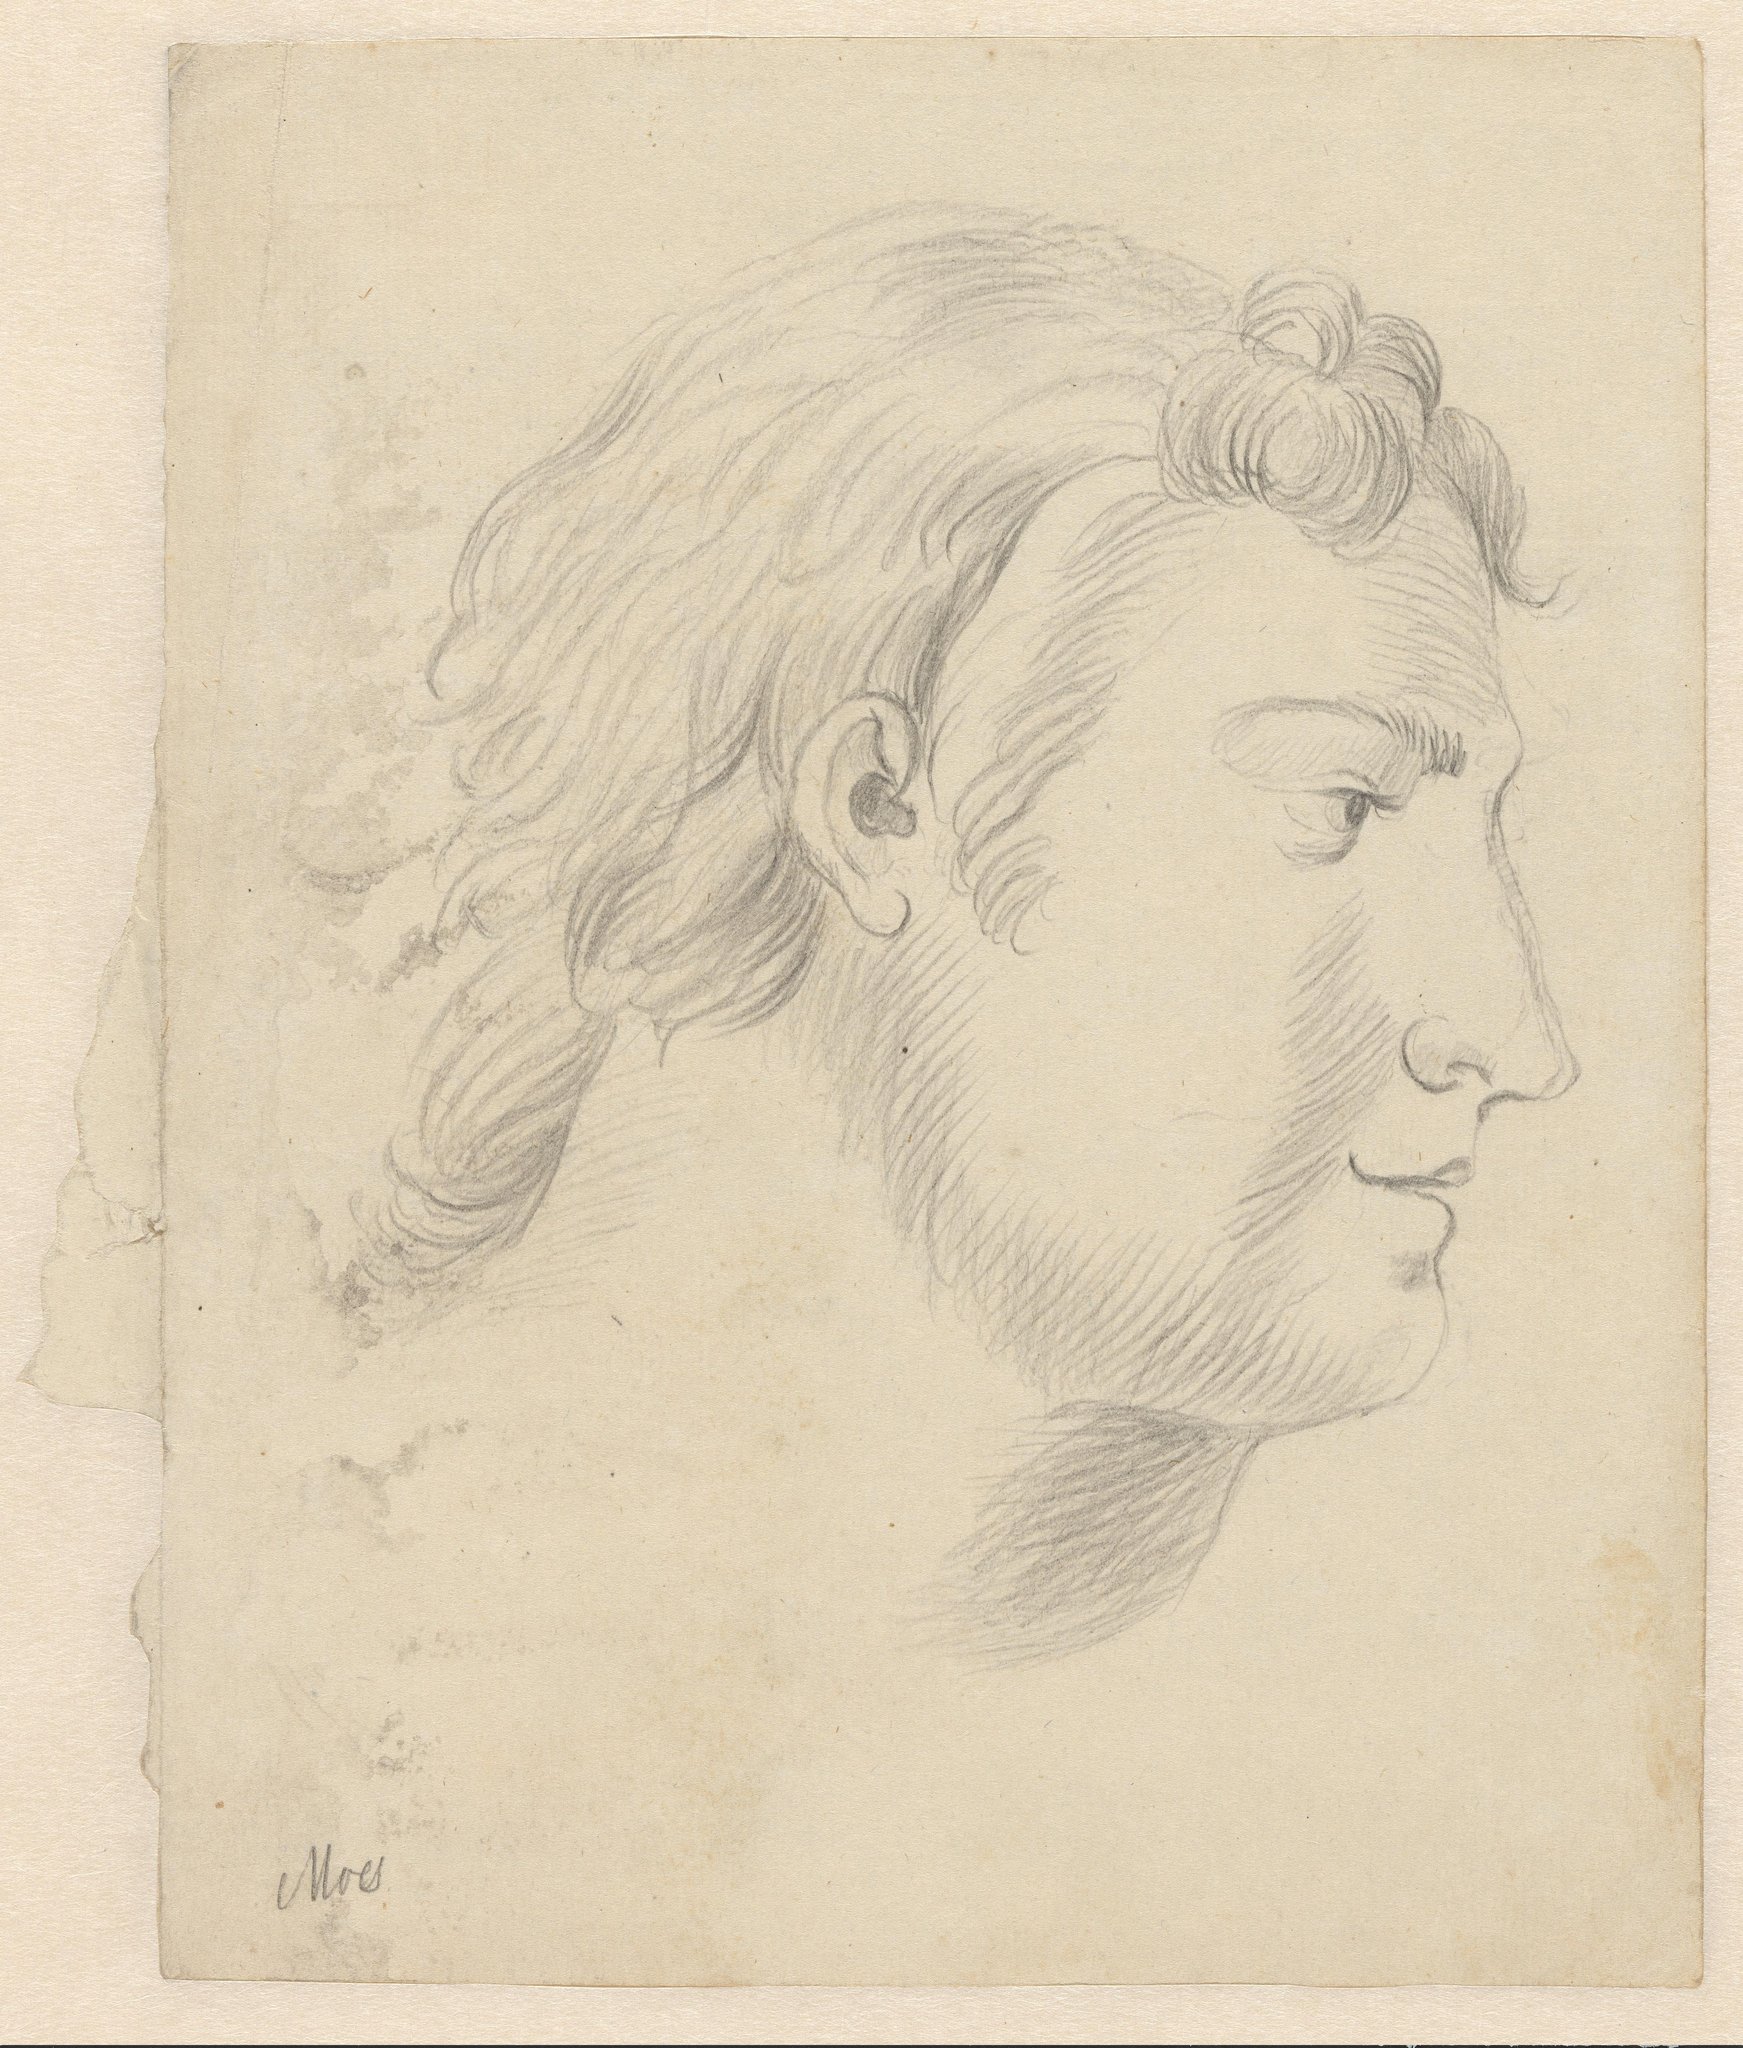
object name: drawing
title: Hoofd van een jonge man en profil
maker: wilhelmina anna sophia alberdingk thijm-kerst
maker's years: 1824-1894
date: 1830-1850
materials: paper, pencil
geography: netherlands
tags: face, youth, adolescent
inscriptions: inscription: ‘Moes’